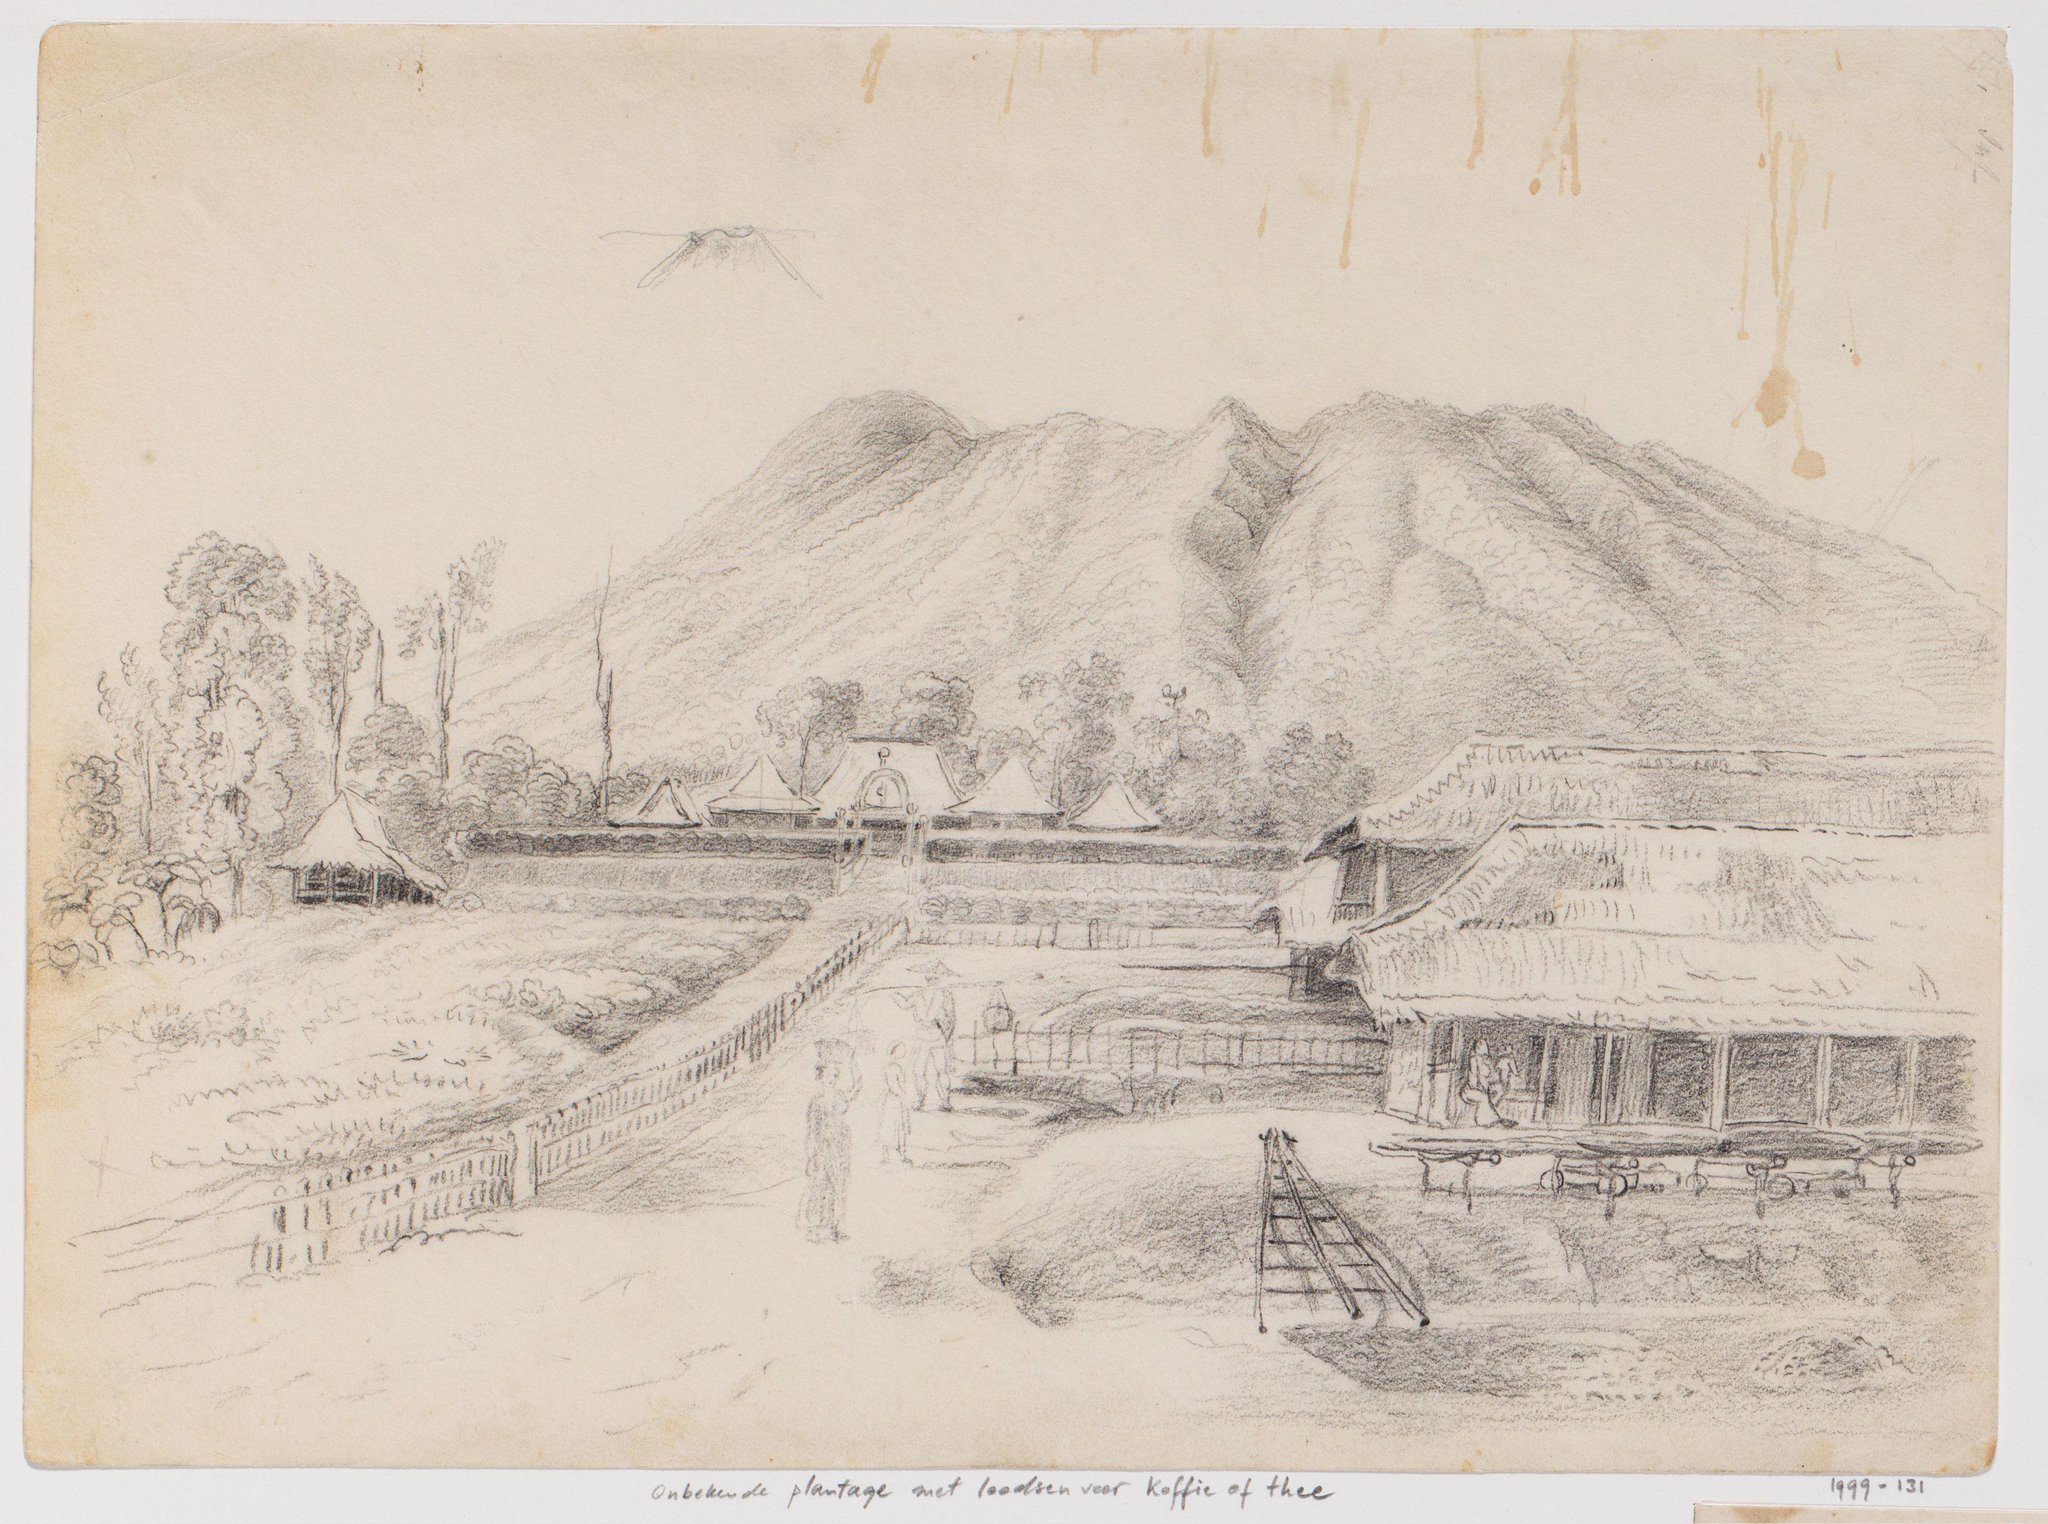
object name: topographical view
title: Gezicht op berg en nederzetting, met loodsen voor koffie of thee, West-Java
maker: adrianus johannes bik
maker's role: draughtsman, print maker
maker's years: 1790-1872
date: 1816-1846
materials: chalk, paper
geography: java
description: artikel over deze collectie in Bulletin van het Rijksmuseum 49 [2001], nr. 4, pp 342 e.v., p. 352, afb. 10